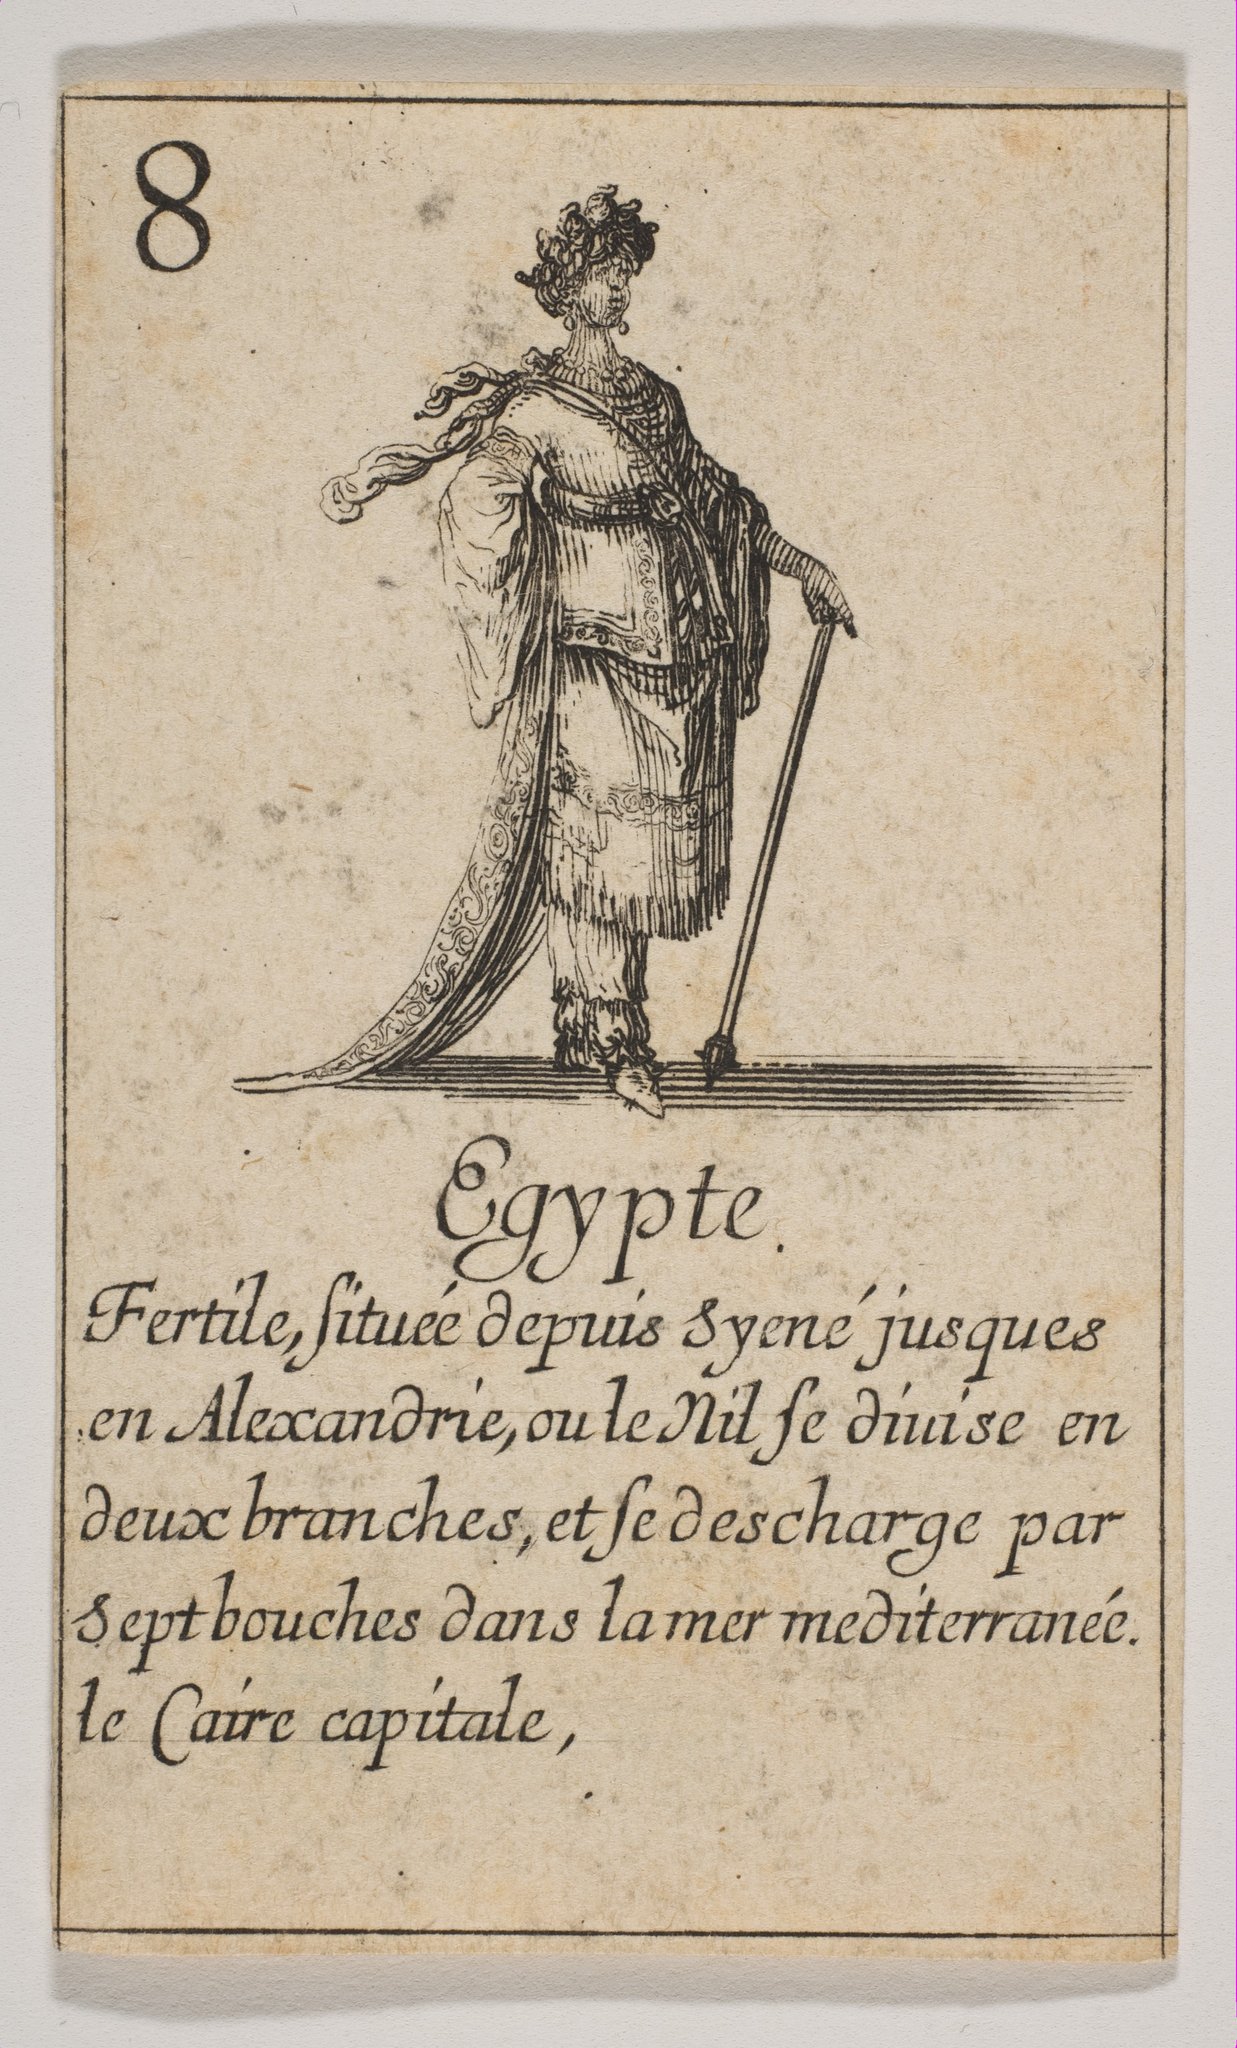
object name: print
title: Egypte, from "Jeu de la Géographie"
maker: stefano della bella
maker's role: artist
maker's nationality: italian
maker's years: 1610-1664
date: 1644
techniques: etching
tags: men